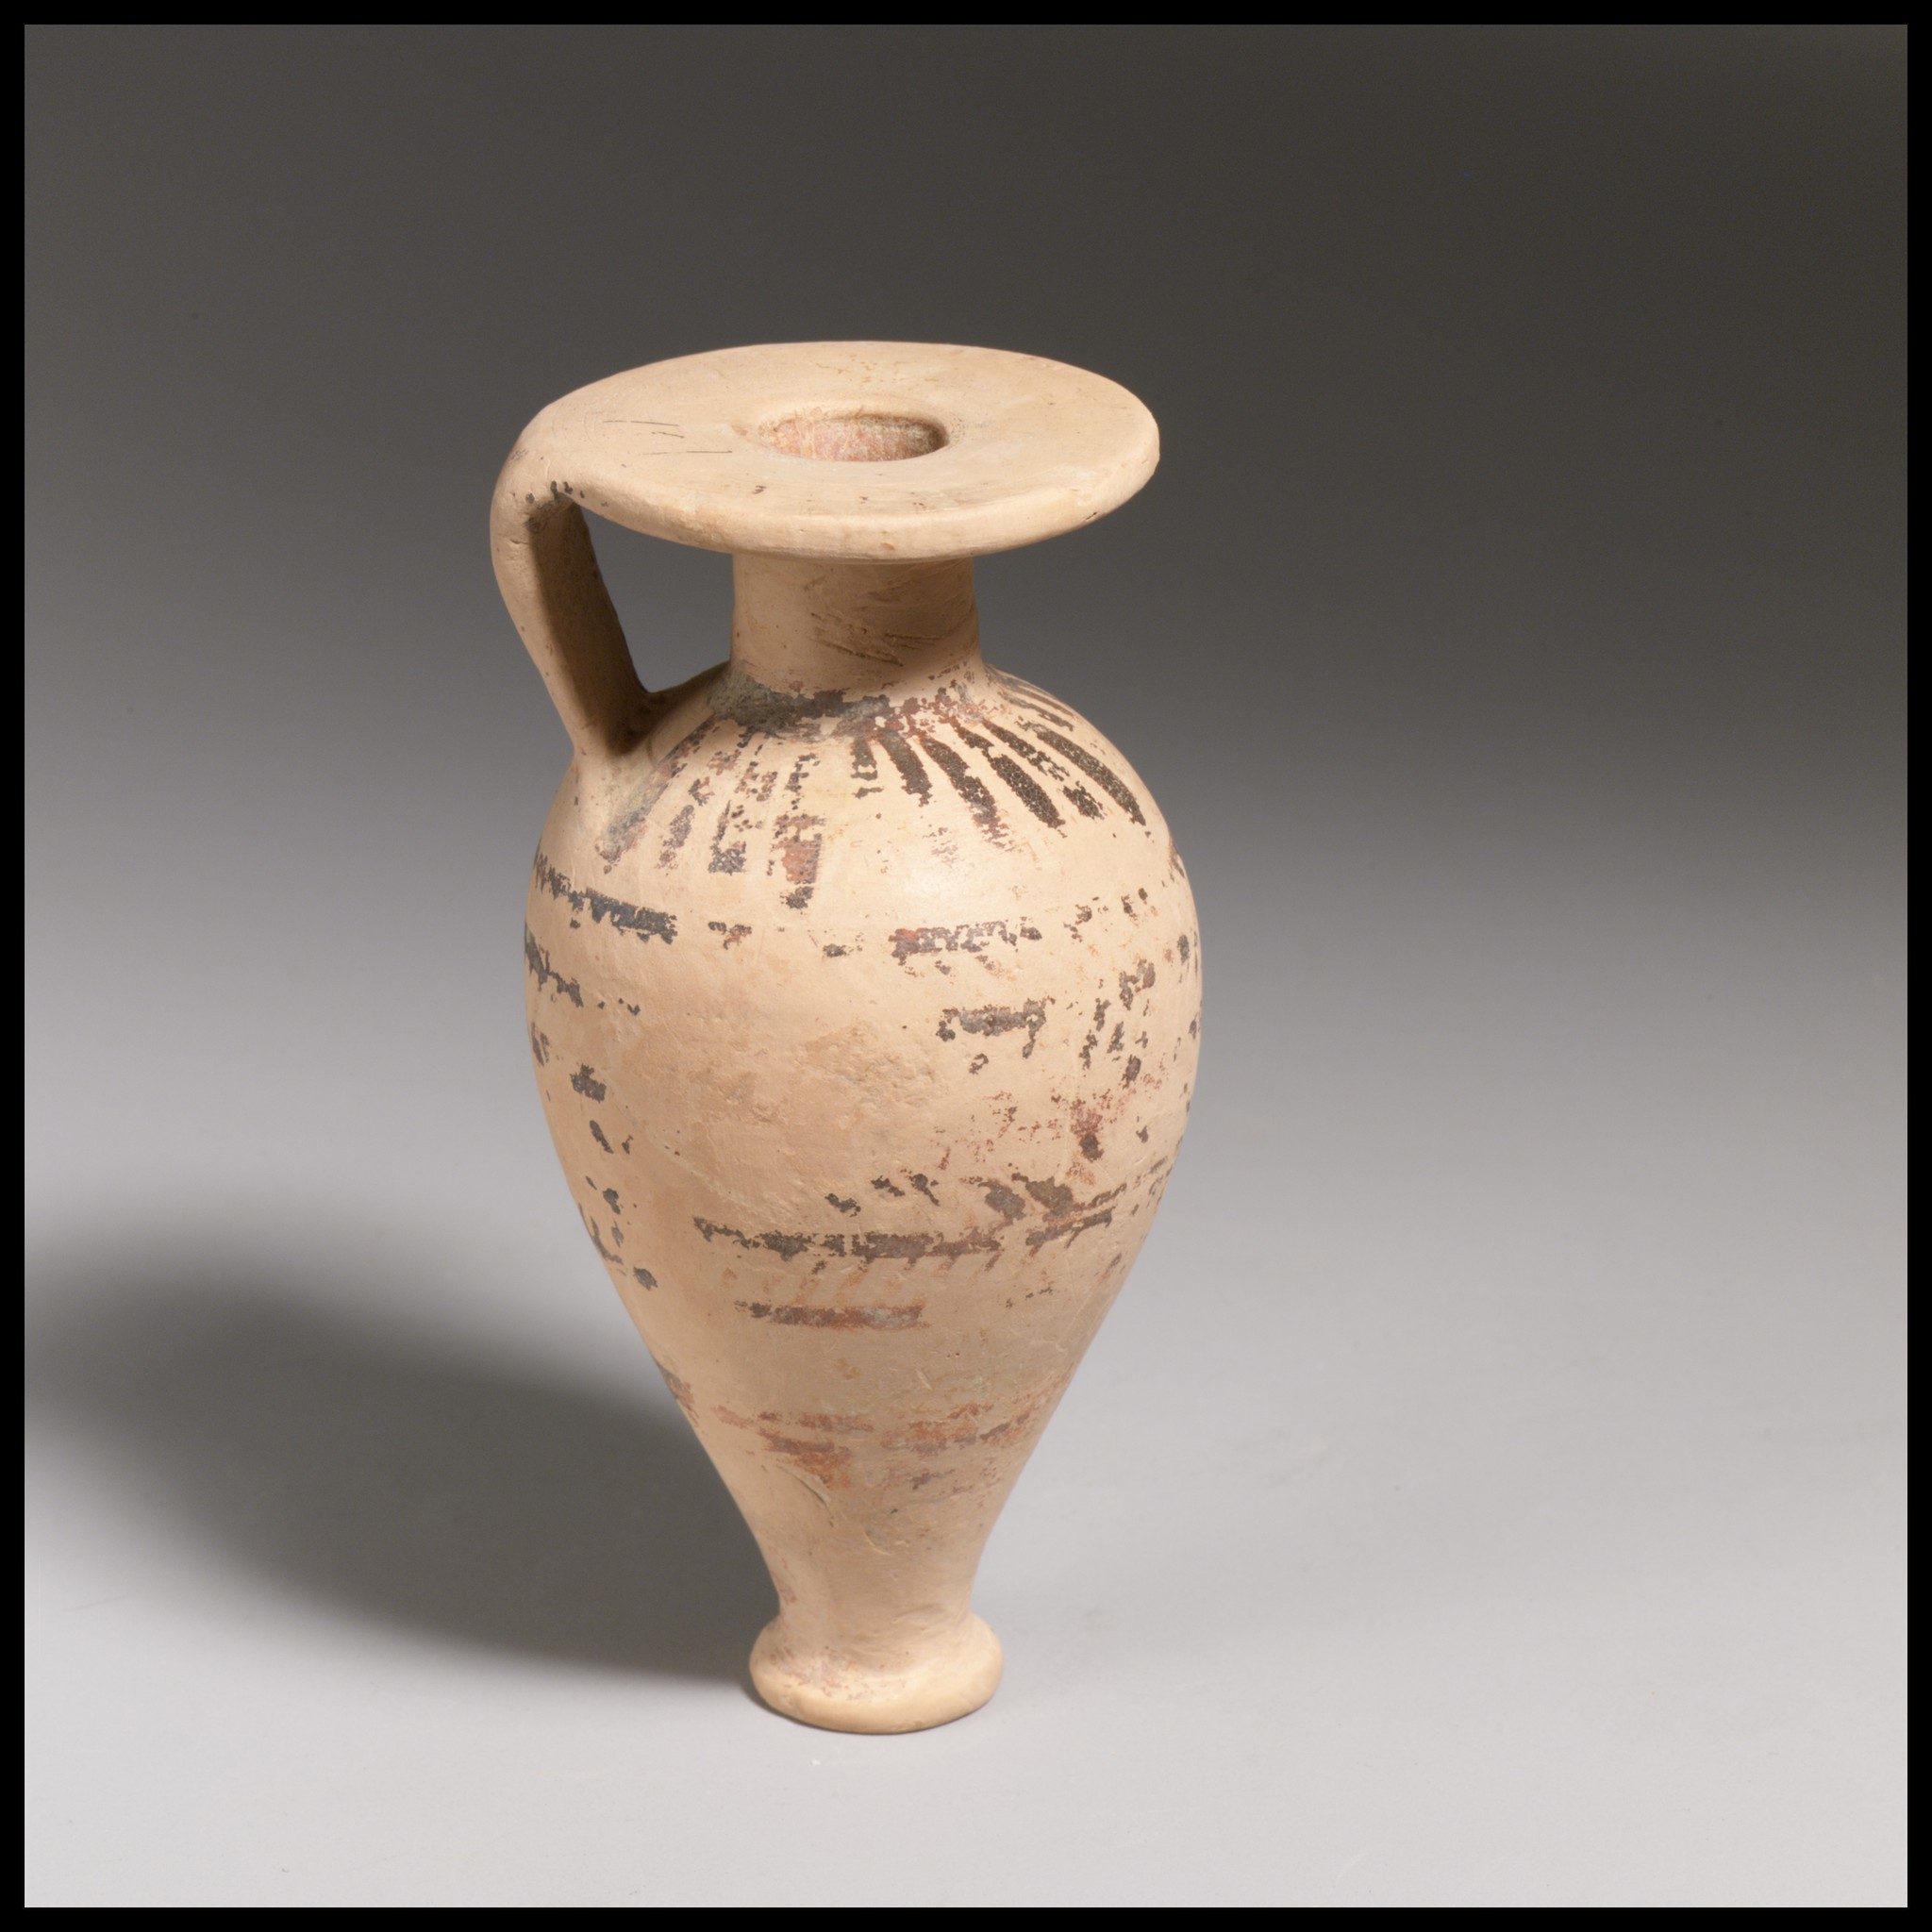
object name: lekythos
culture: etruria or italic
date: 700-601 BCE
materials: terracotta